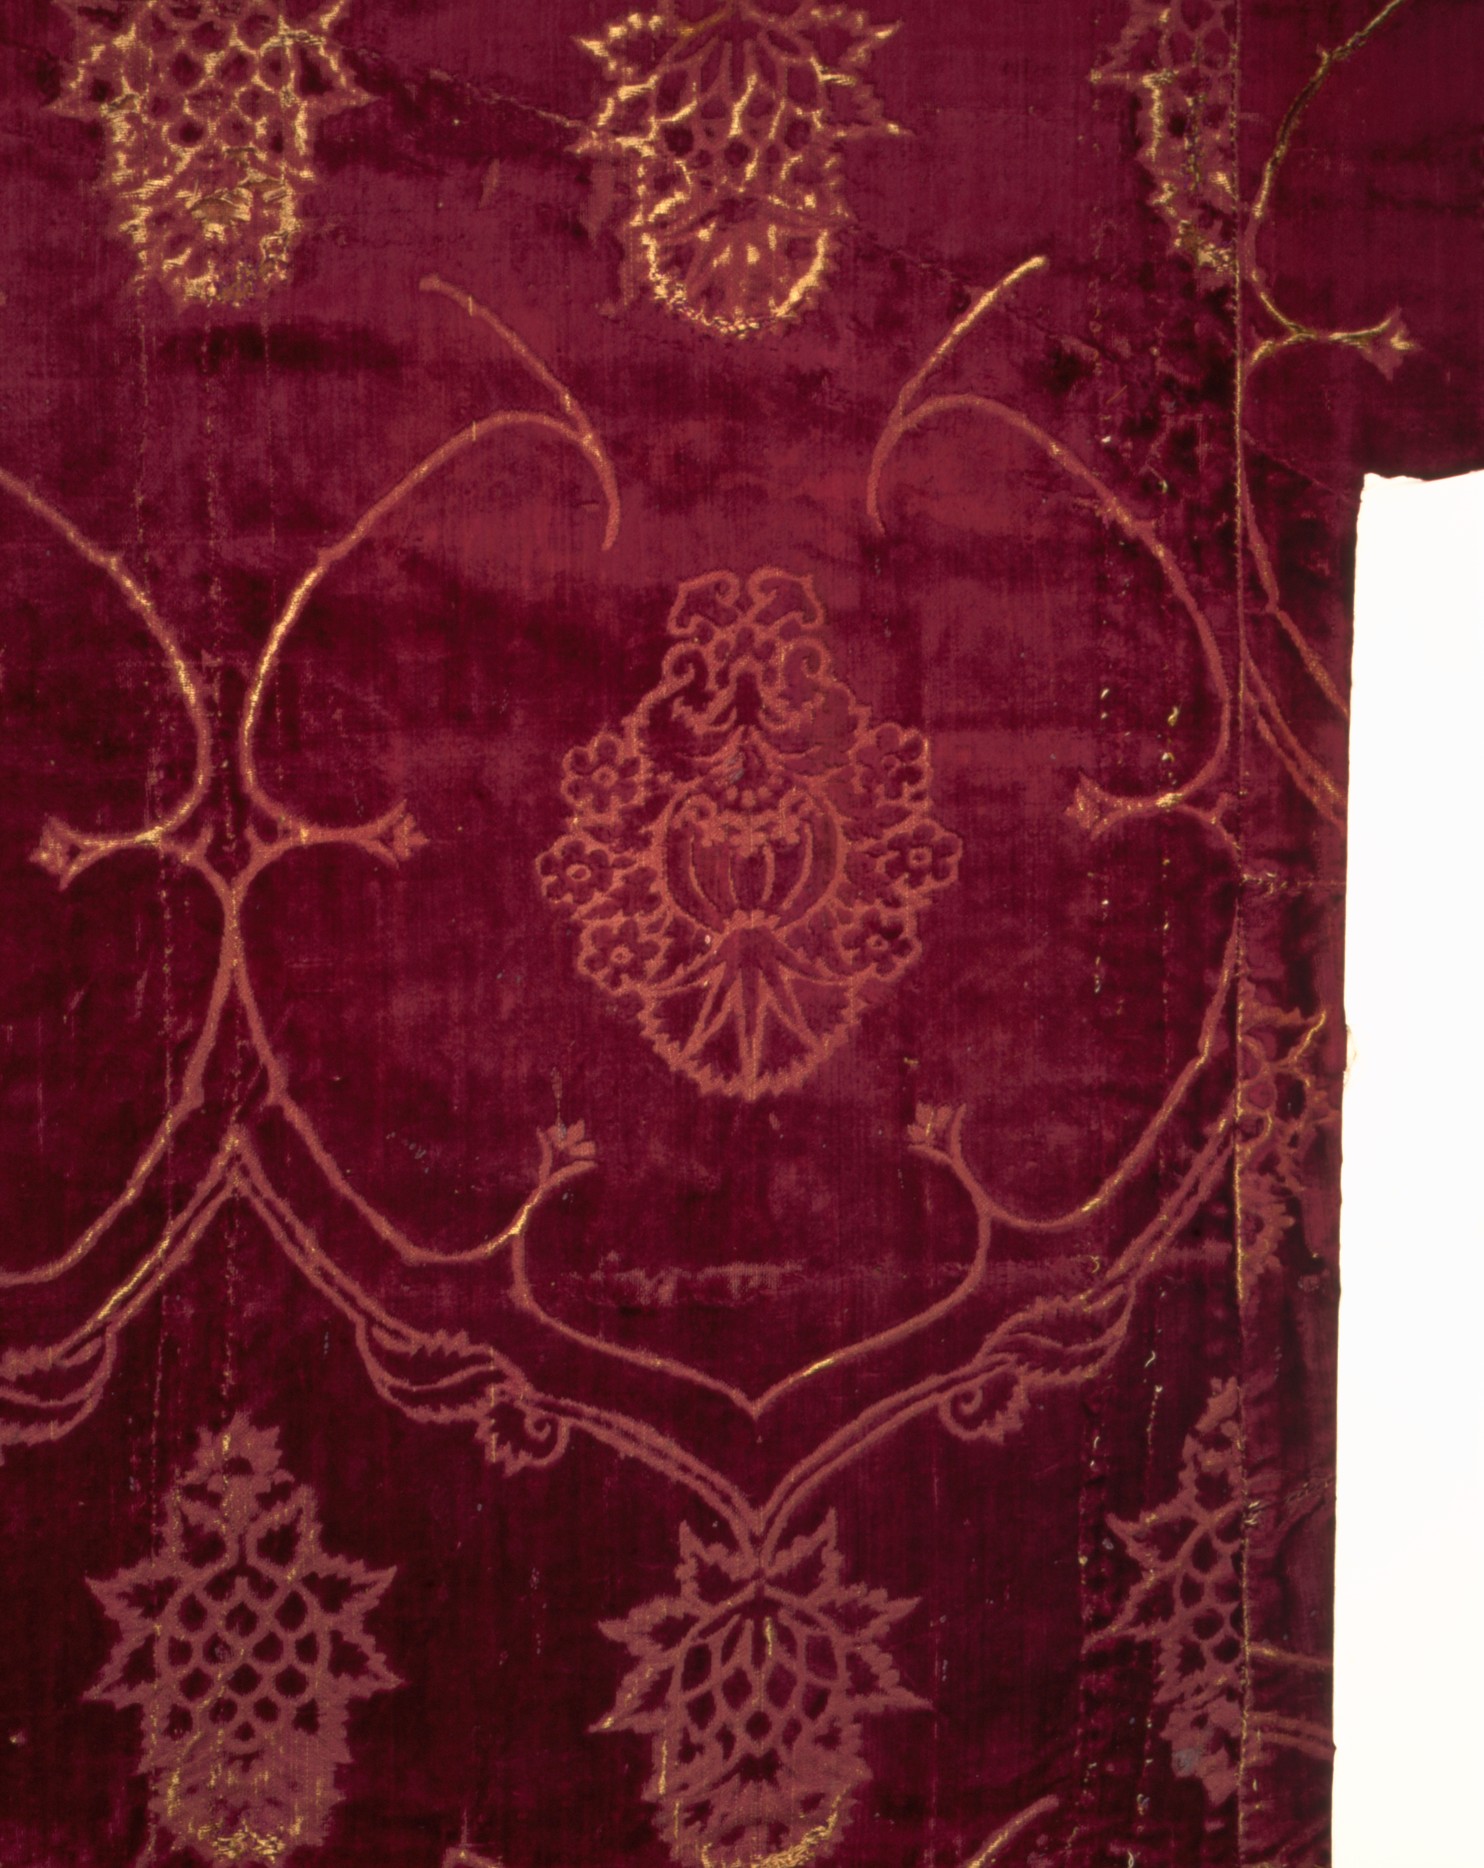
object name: textile panel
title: Panel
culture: italian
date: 1434-1466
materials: linen, silk